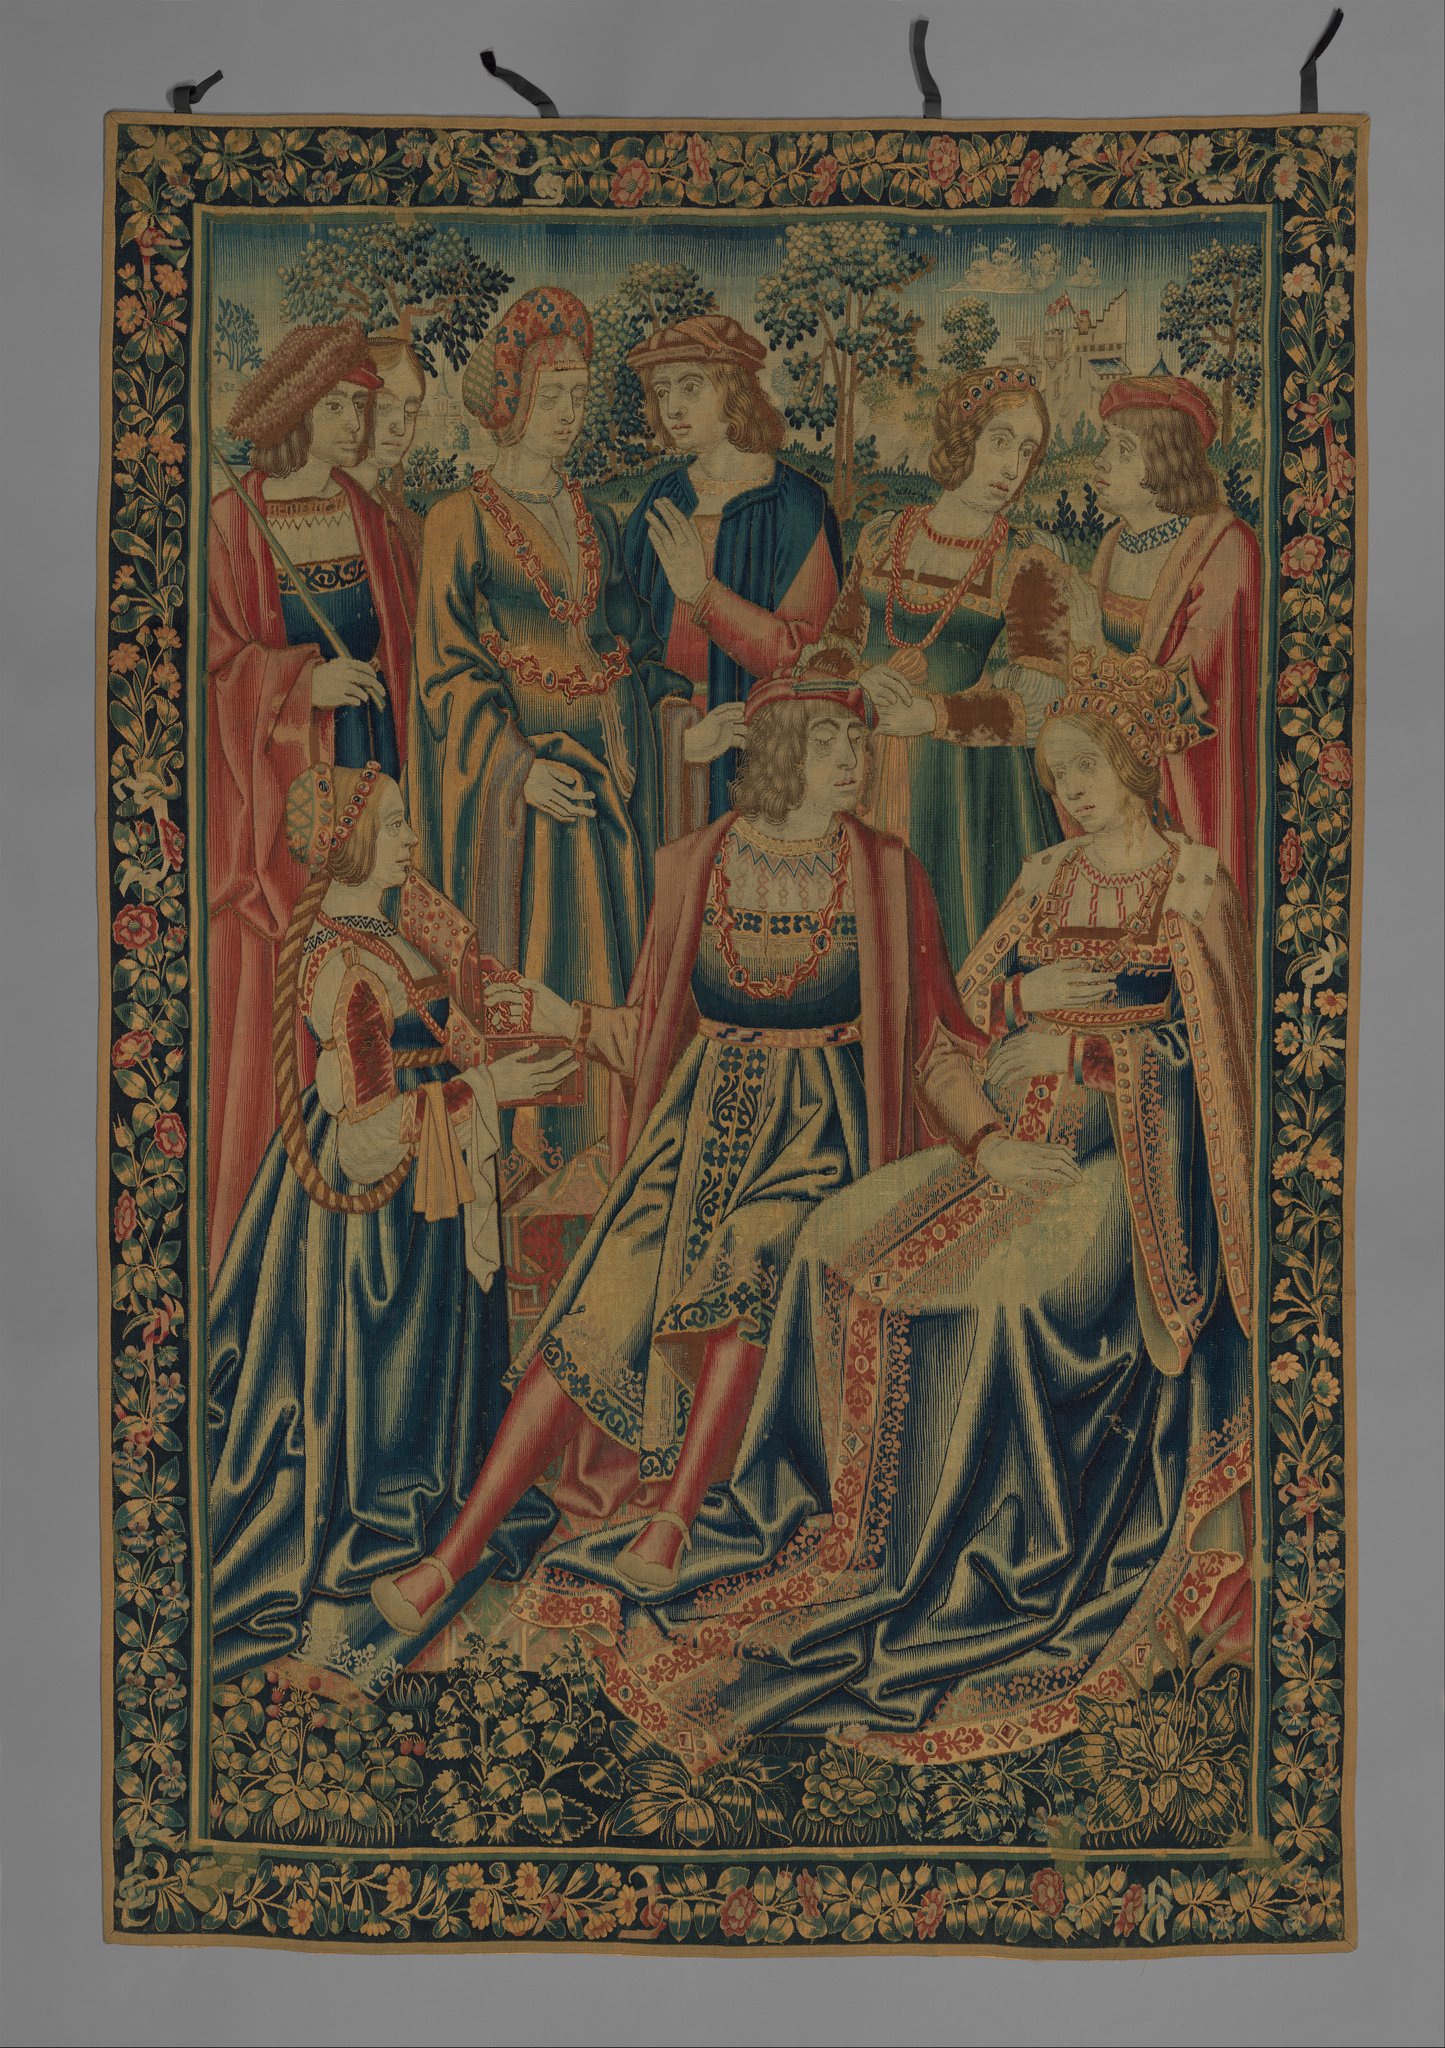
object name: tapestry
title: Two Episodes from the Parable of the Prodigal Son: The Prodigal Offering Jewels to Luxuria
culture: south netherlandish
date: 1510-1525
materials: silk, wool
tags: men,women